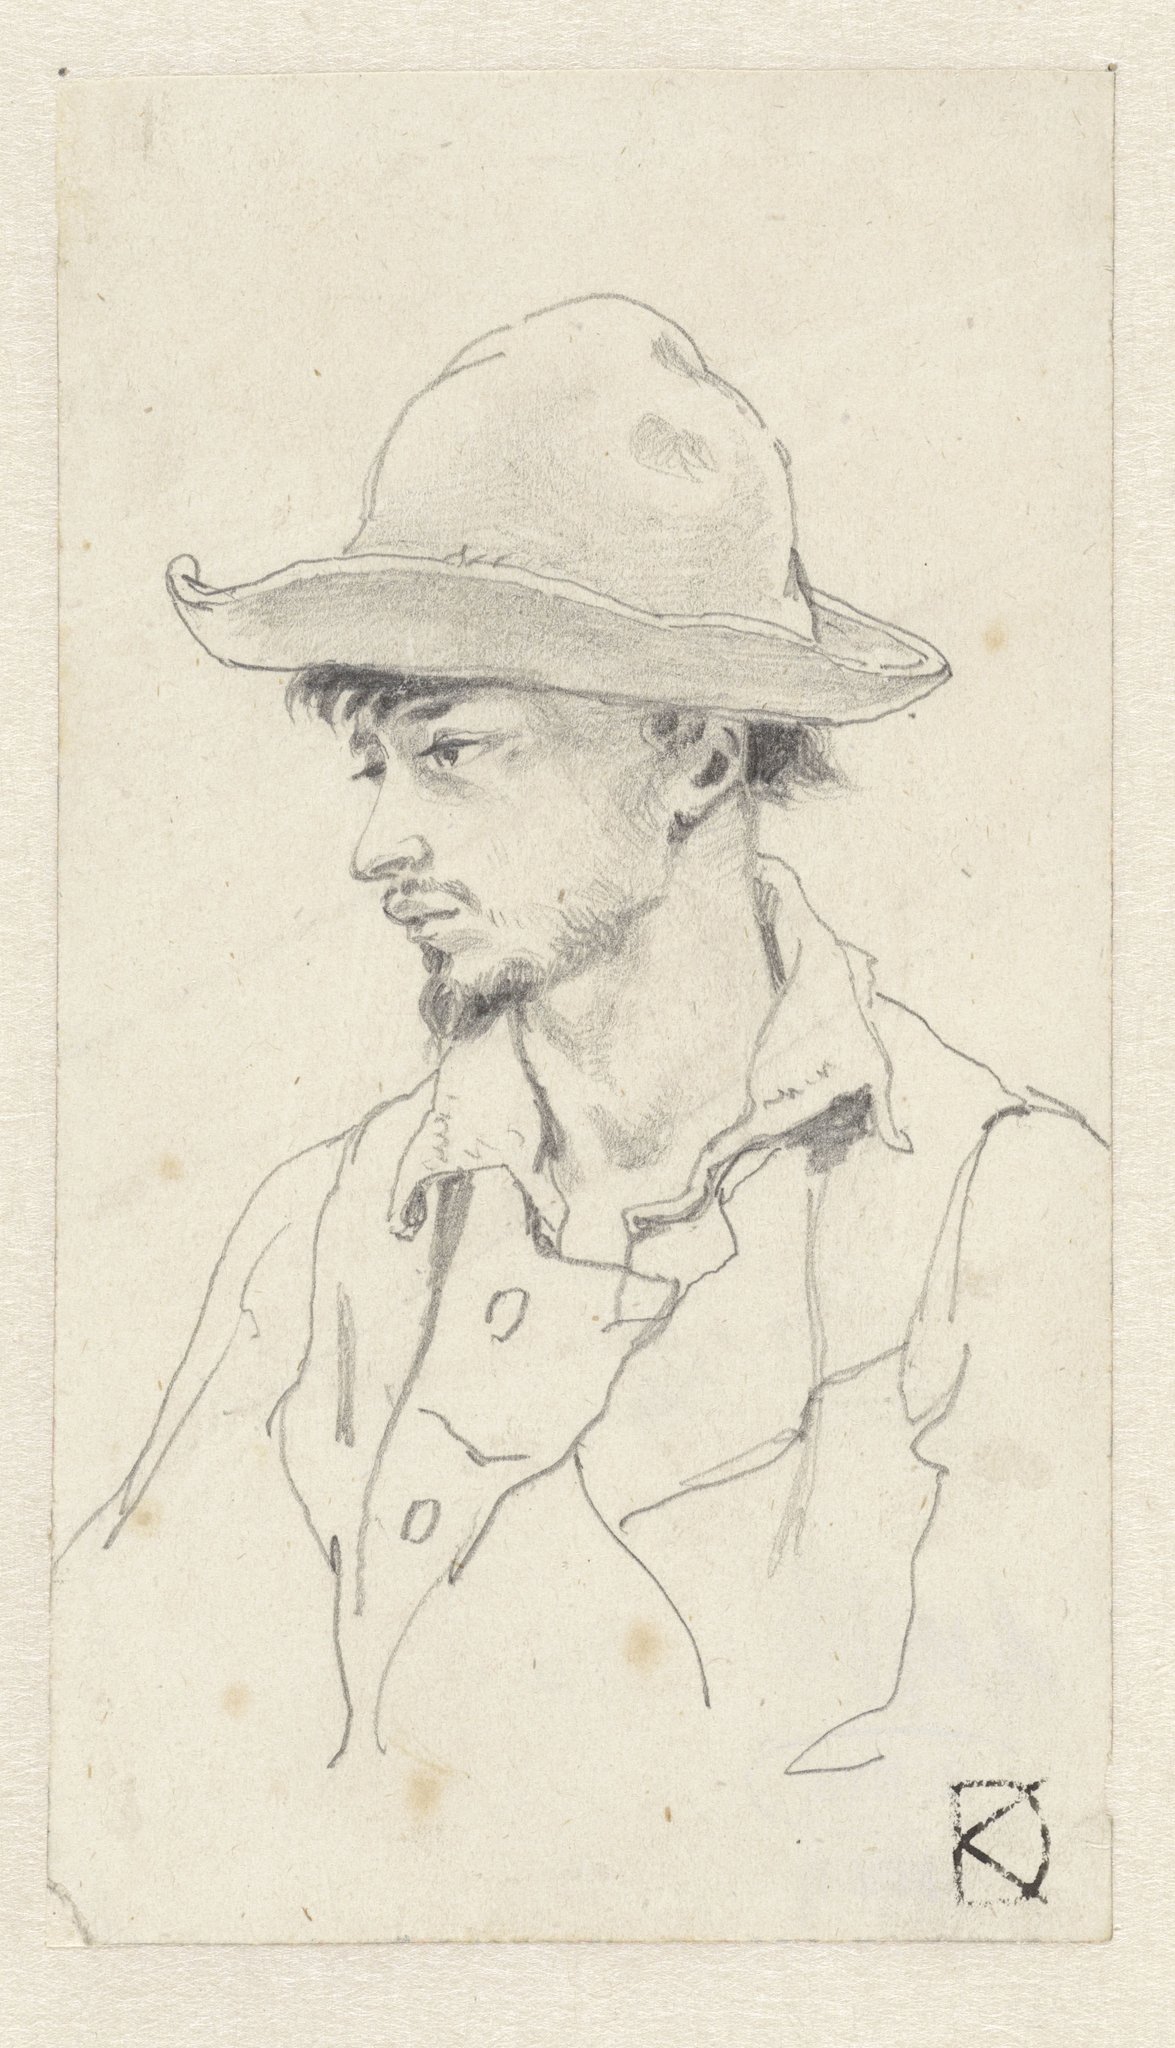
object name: drawing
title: Mansbuste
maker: johan daniël koelman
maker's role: draughtsman, print maker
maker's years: 1831-1857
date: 1841-1857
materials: paper, pencil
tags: male sex; man